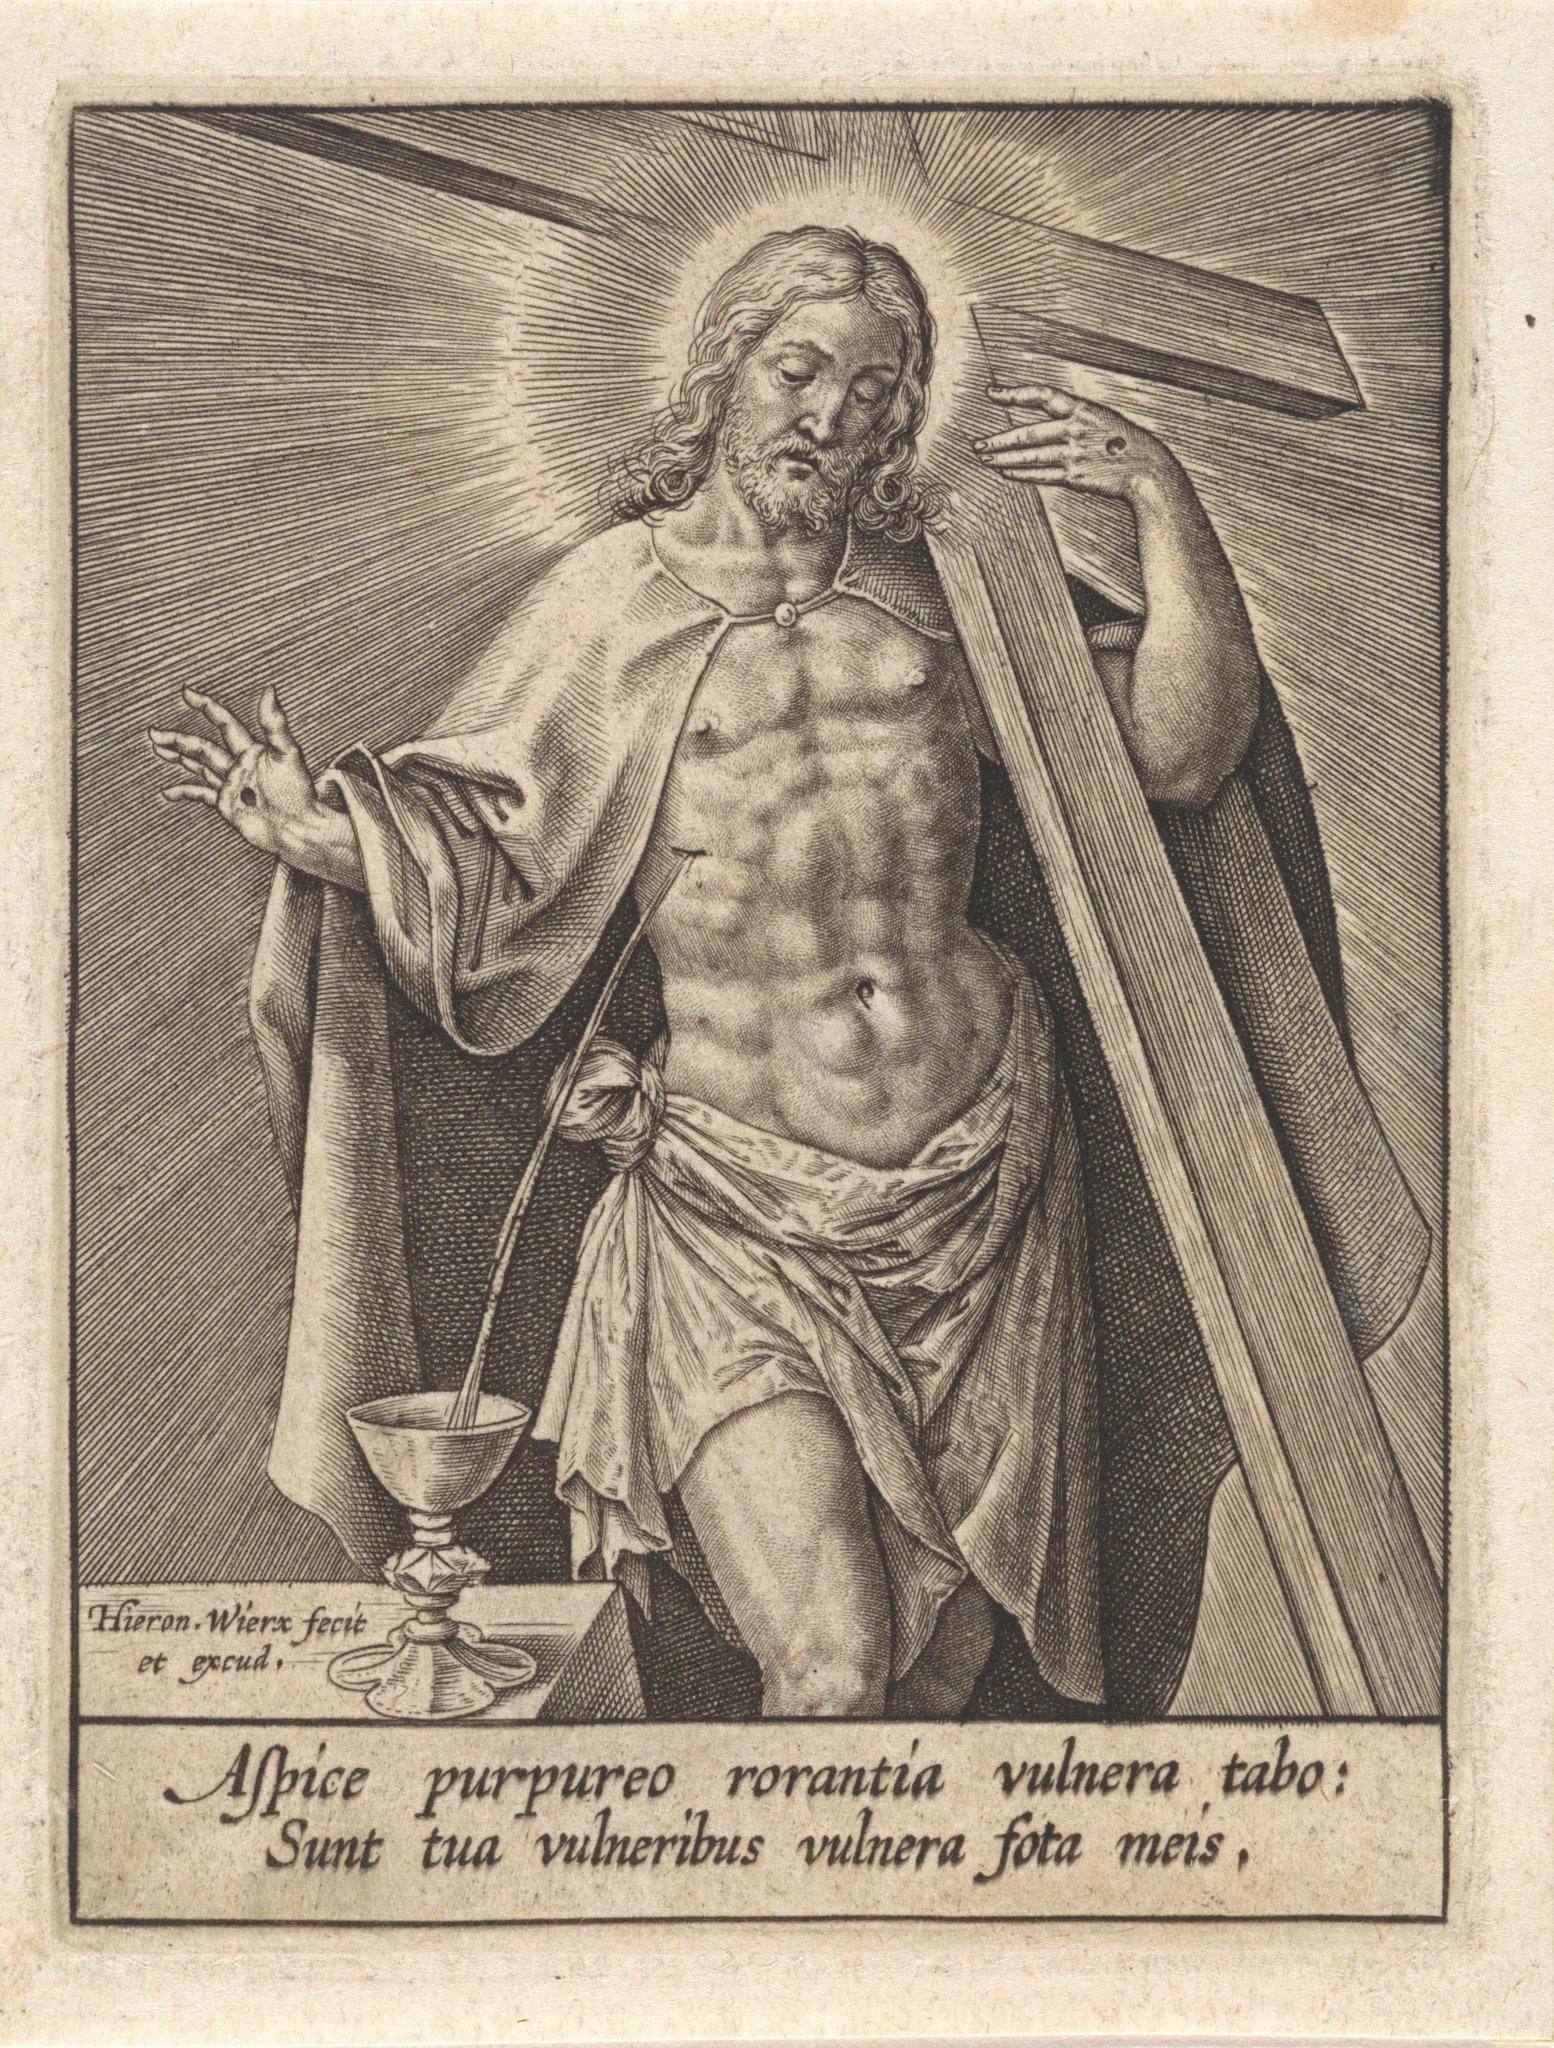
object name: print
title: Christus met zijn kruis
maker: hieronymus wierix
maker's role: draughtsman, print maker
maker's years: 1553-1619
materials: paper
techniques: engraving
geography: antwerp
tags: types of adult christ (alone), blood spouting from christ's wounds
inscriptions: collector's mark: Lugt 2228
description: Christus draagt zijn kruis op zijn schouder. Uit de wond in zijn zijde stroomt het bloed in een kelk. In de marge een tweeregelig onderschrift in het Latijn.